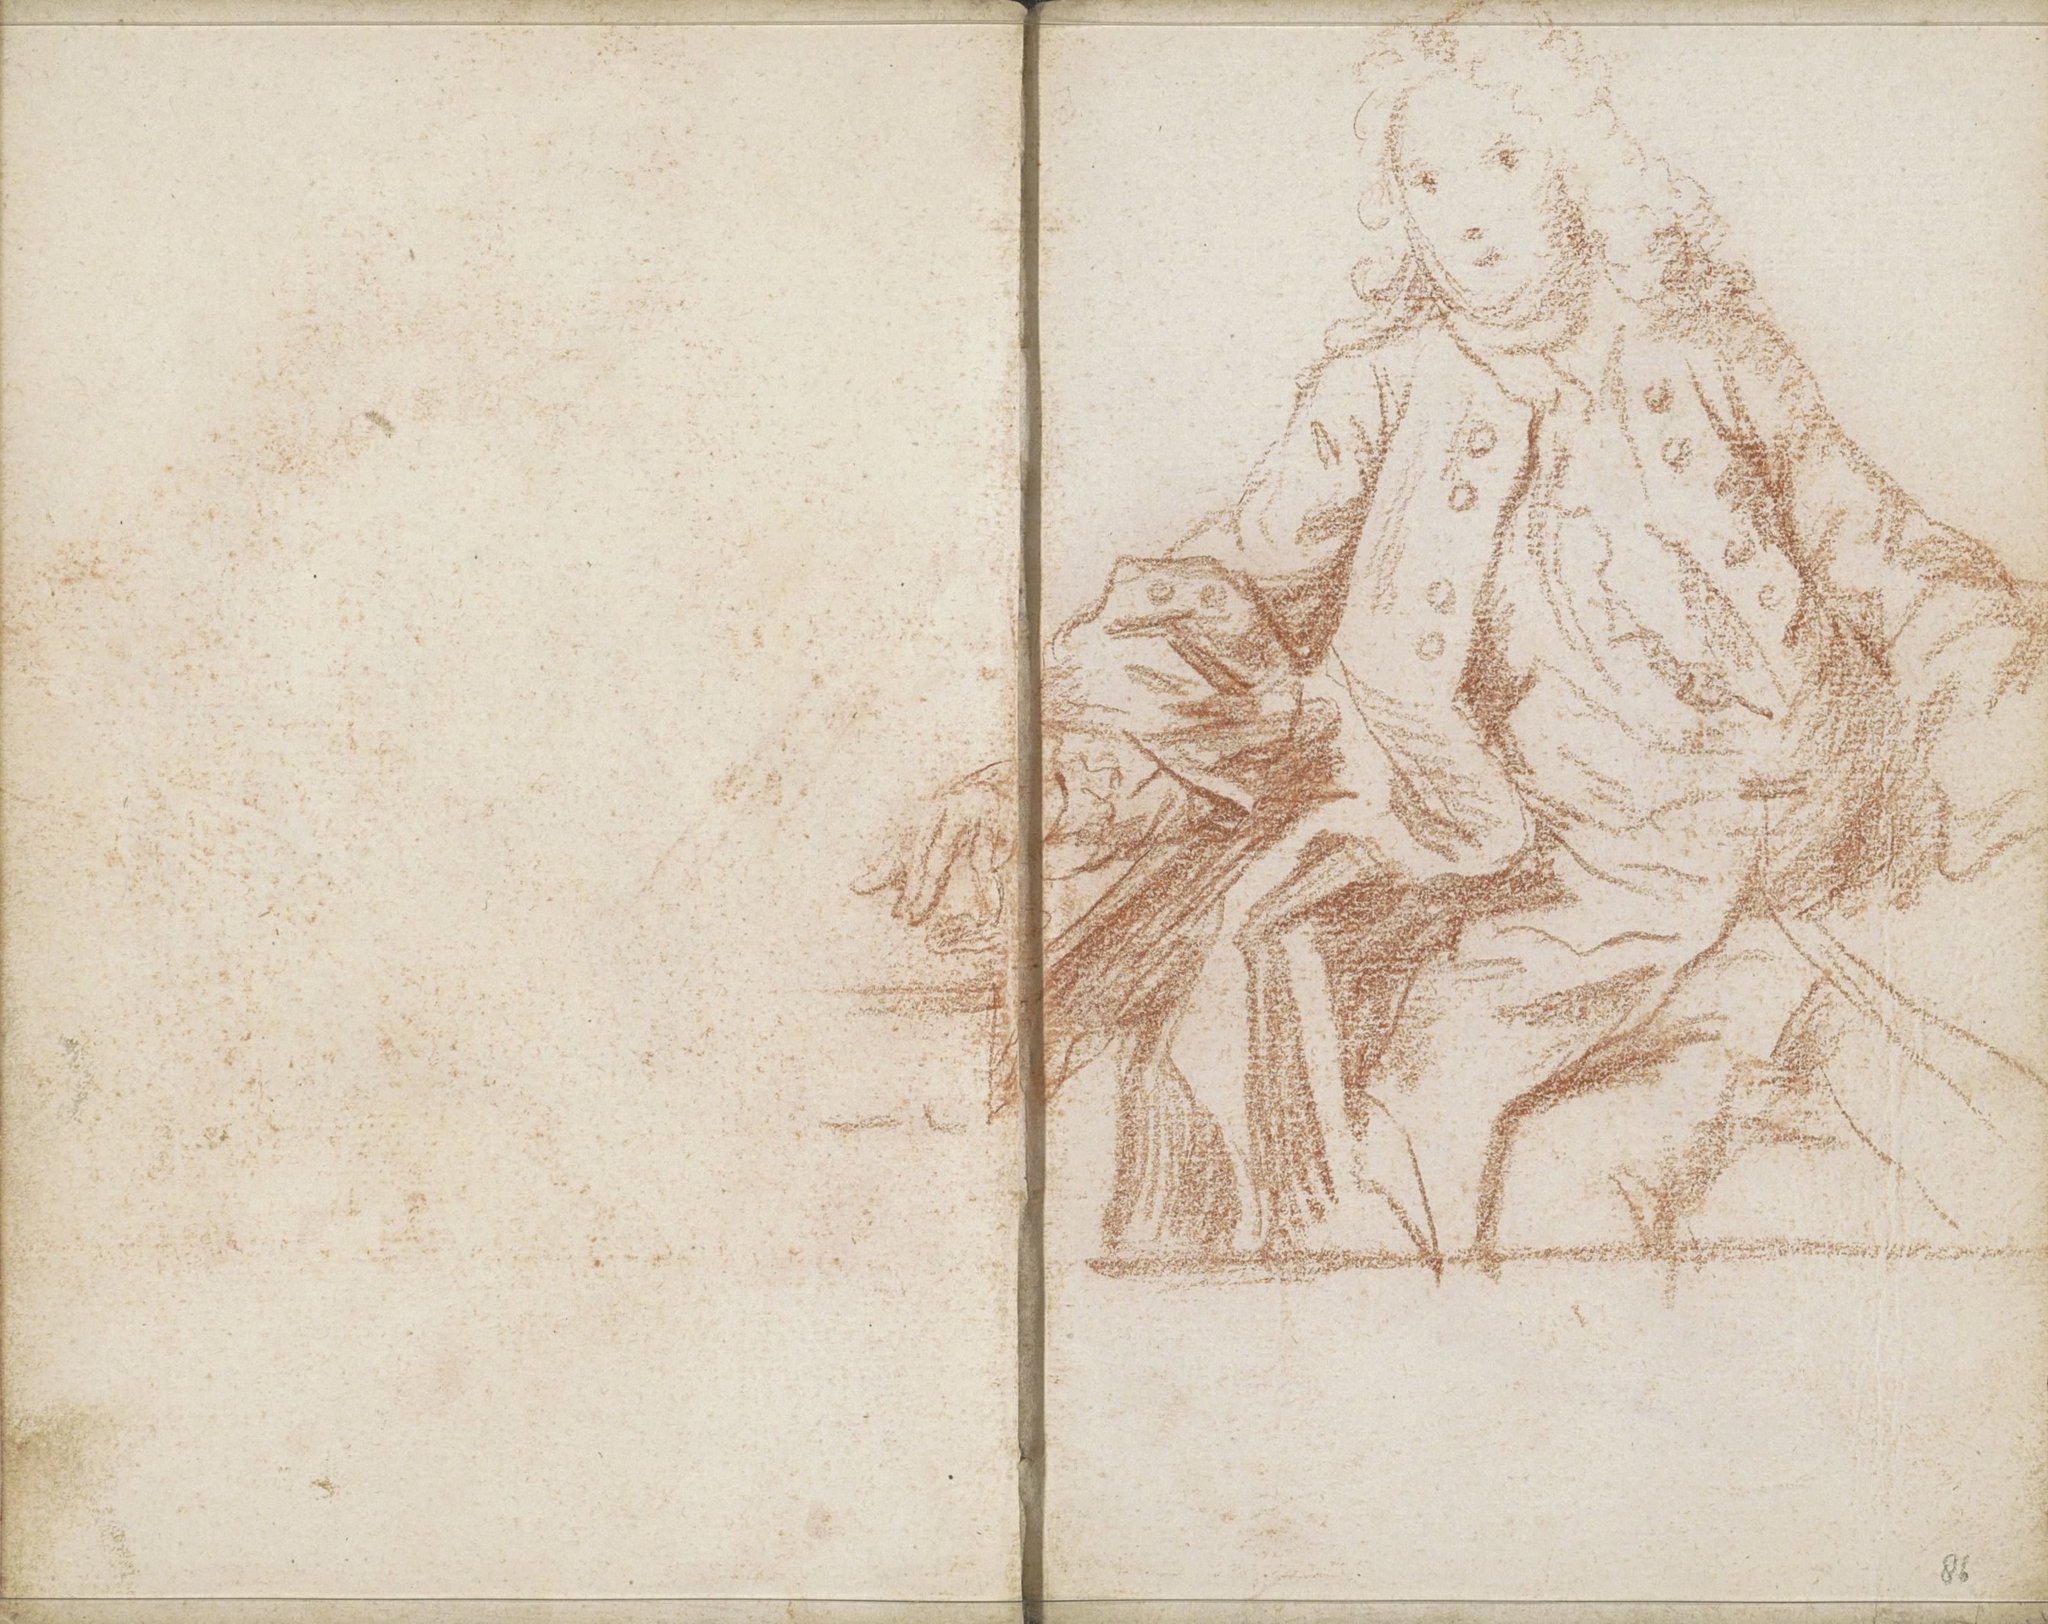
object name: sketchbook leaf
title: Zittende man naast een tafel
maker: petrus johannes van reysschoot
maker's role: draughtsman, print maker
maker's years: 1702-1772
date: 1710-1772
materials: chalk, paper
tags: sitting figure, table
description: Blad 85 verso en 86 recto uit een schetsboek met 105 bladen.